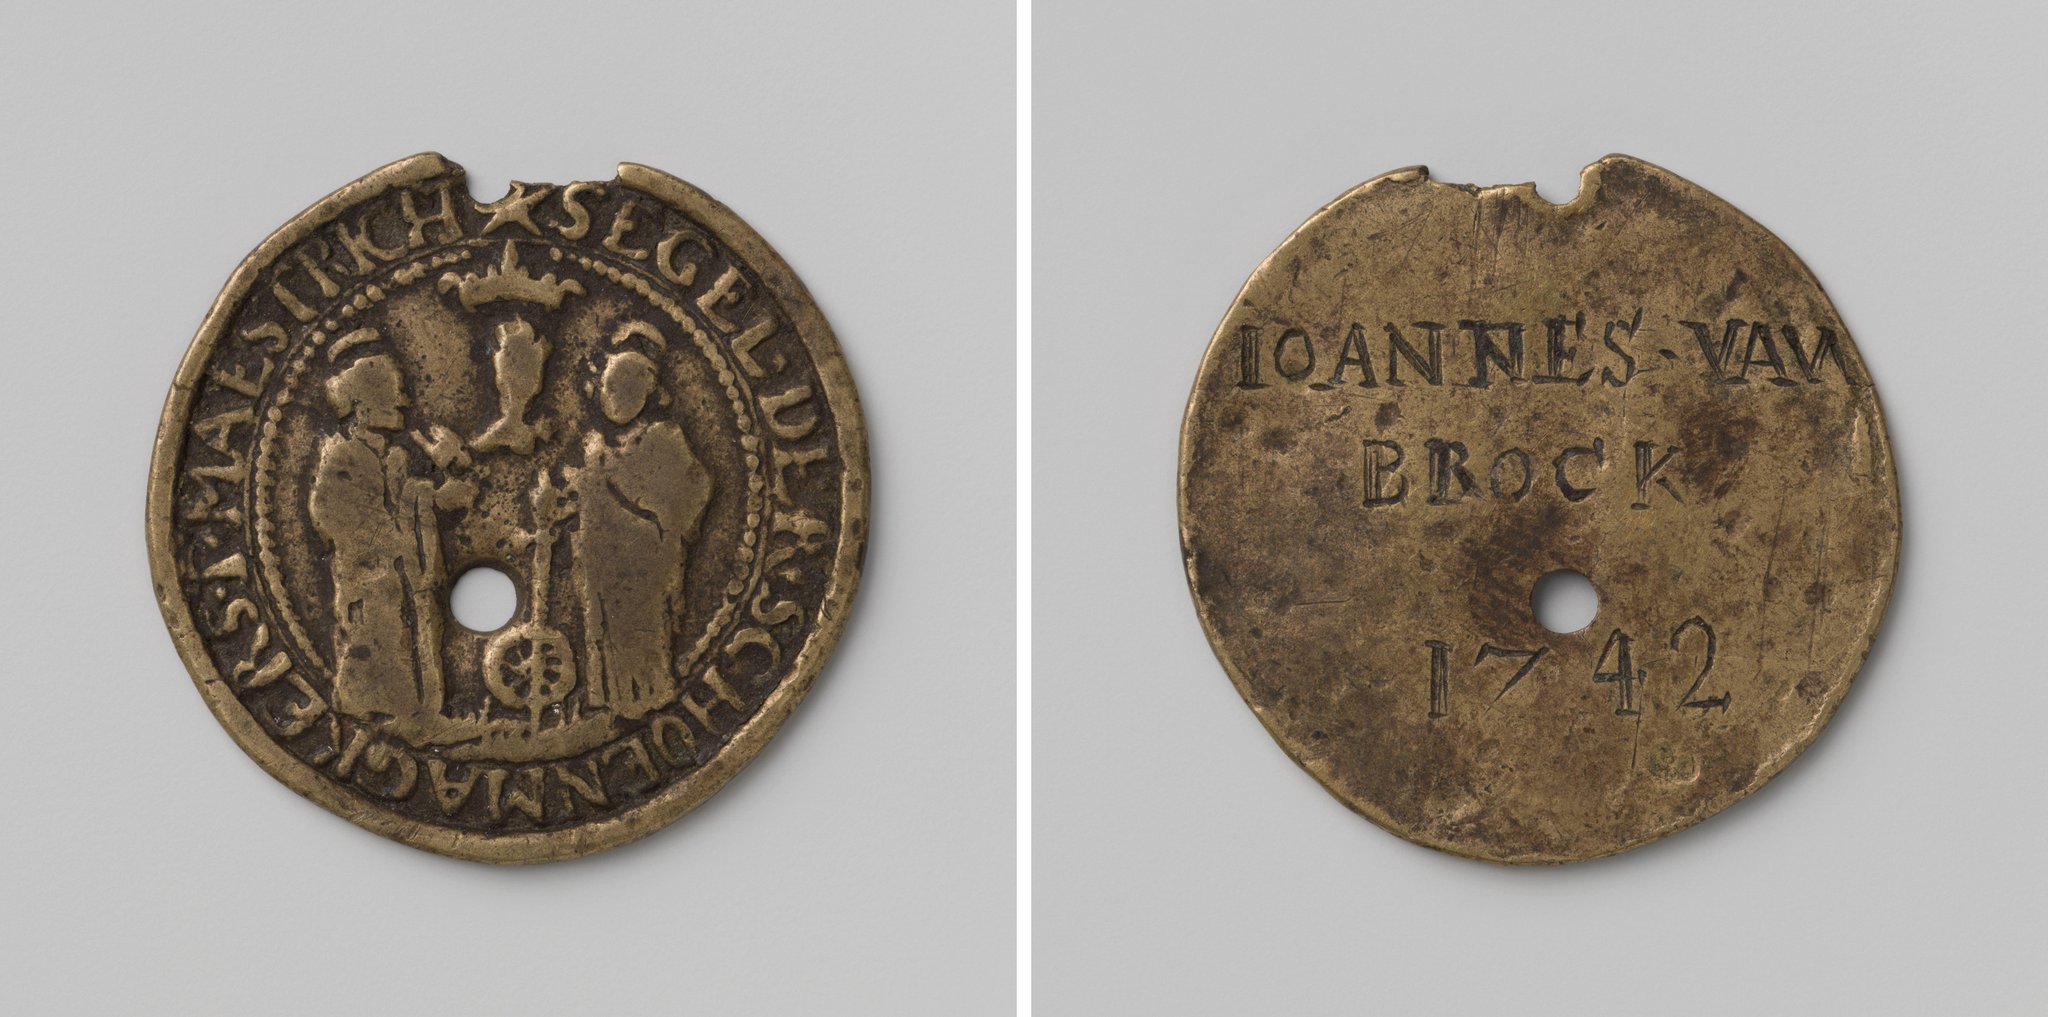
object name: medal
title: Schoenmakersgilde van Maastricht, gildepenning van Joannes van Brock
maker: Anonymous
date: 1742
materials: brass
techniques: casting, engraving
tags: maastricht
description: Messing penning met gat in midden. Voorzijde: St. Crispinus met schoen of leest in uitgestrekte linkerhand en St. Crispinianus met in rechterhand een zwaard dat door een rad is gestoken; tussen beiden: gekroonde laars binnen omschrift. Keerzijde: opschrift